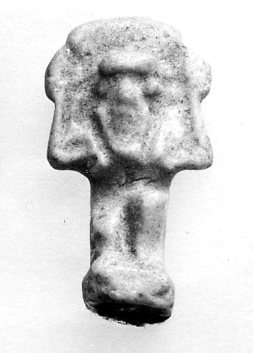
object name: amulet, shu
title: Shu amulet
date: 664-332 BCE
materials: faience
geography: egypt